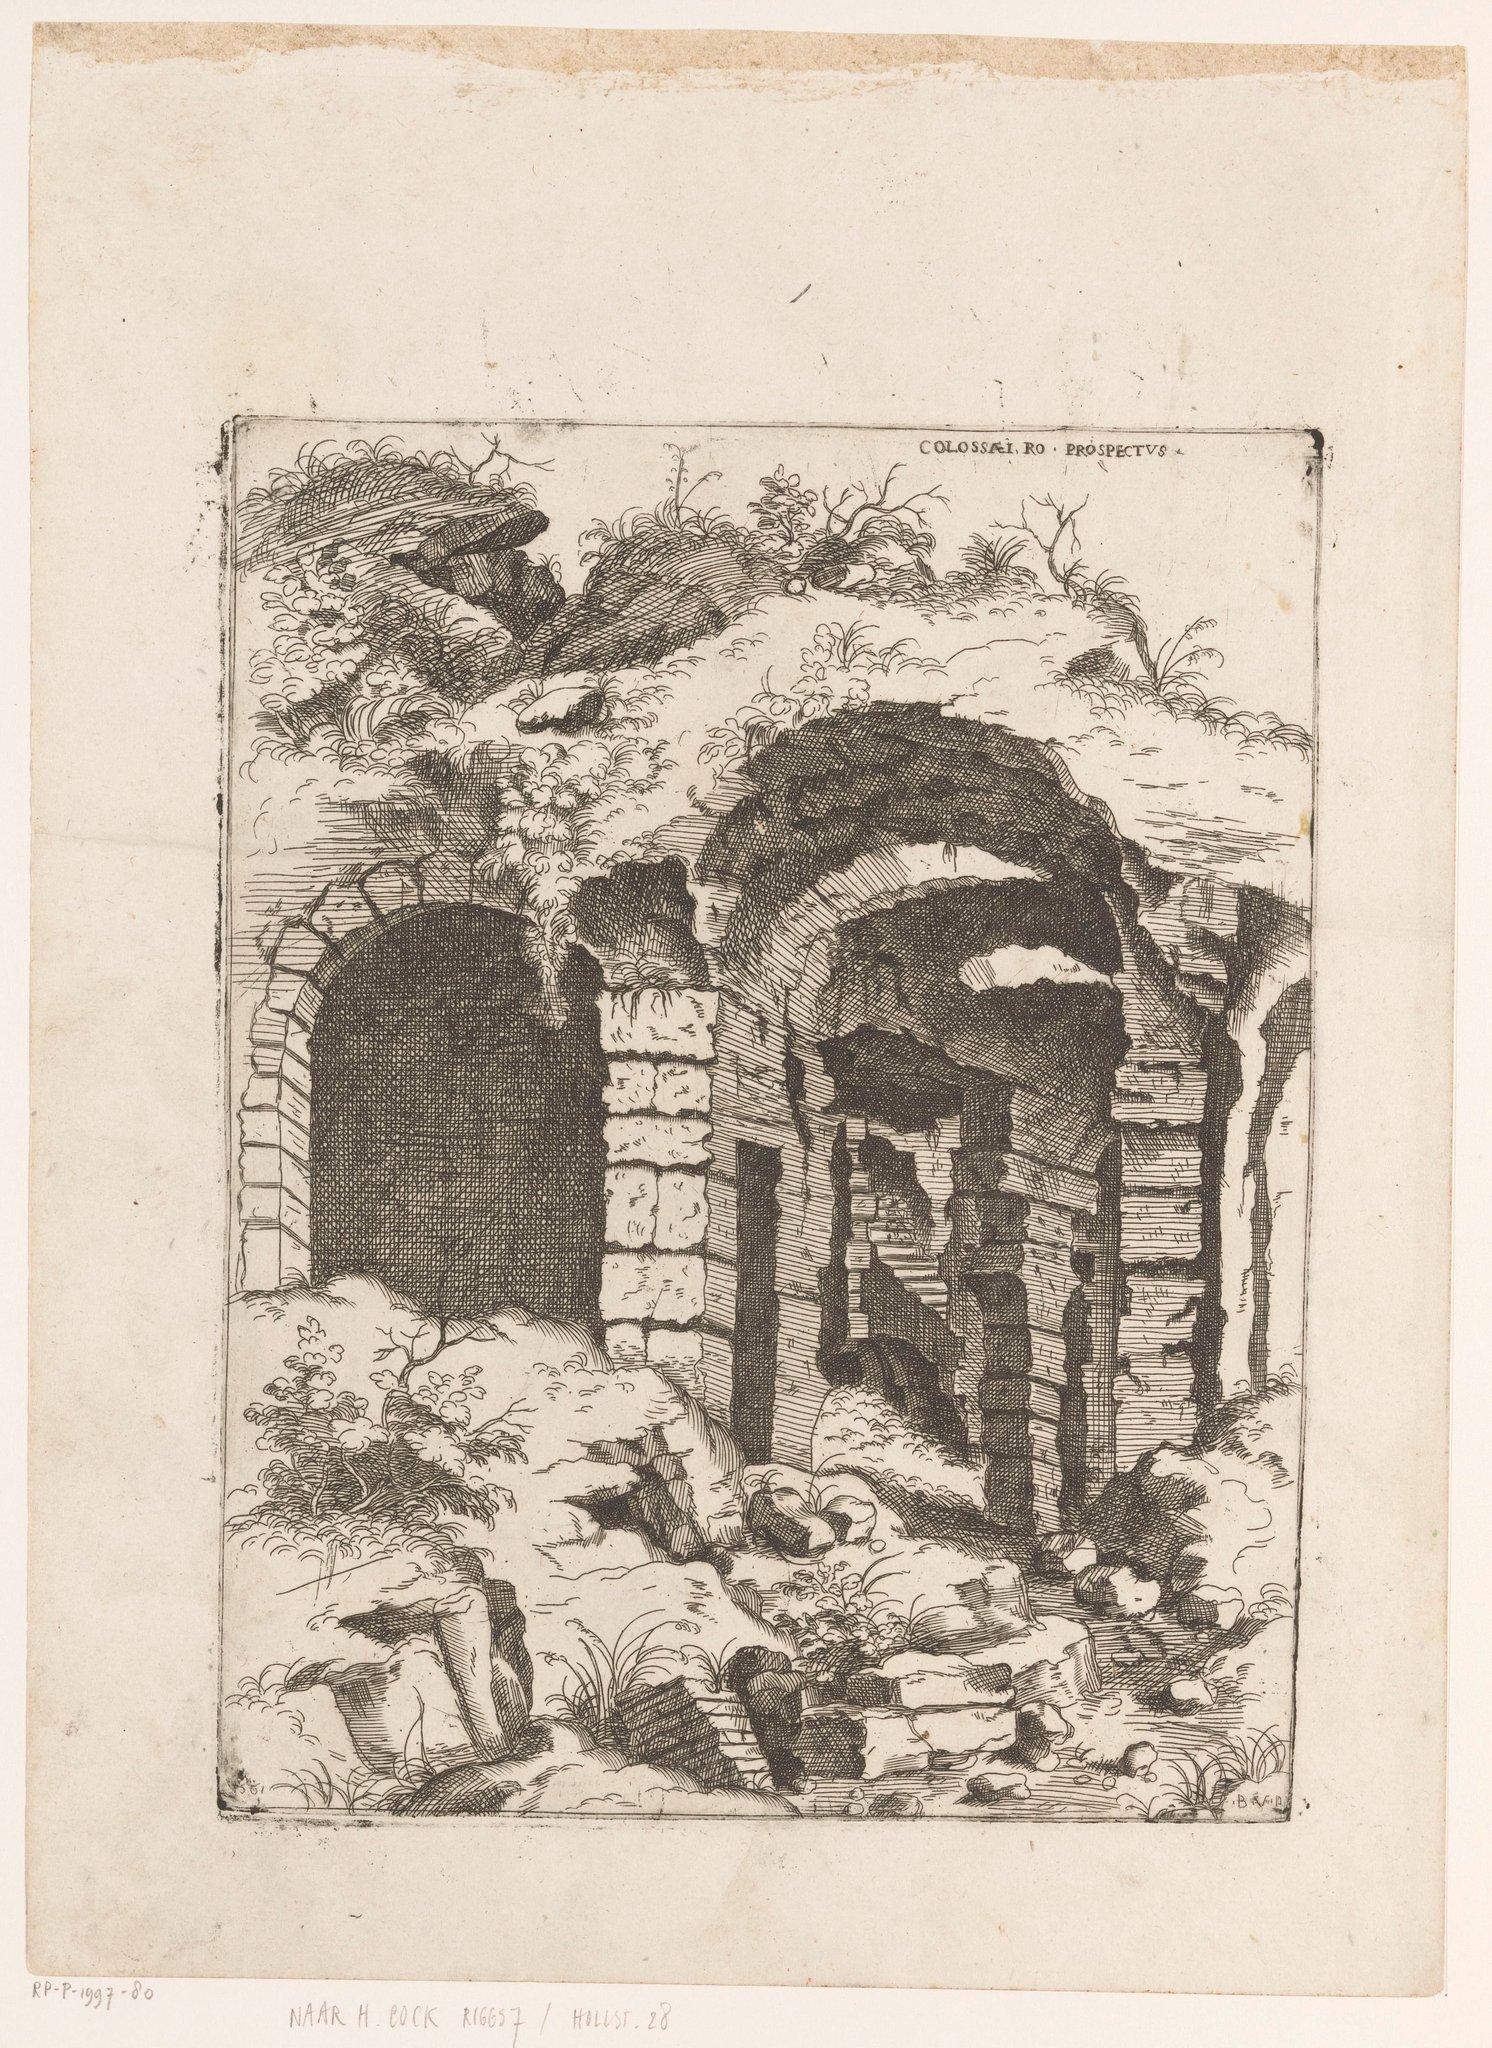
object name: book illustration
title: Colossaei ro prospectus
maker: giovanni battista pittoni (i)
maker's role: print maker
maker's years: 1520-1583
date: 1561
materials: paper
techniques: etching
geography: italy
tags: ruin of a building ~ architecture, landscape with ruins, theatre (building) - aa - open-air performances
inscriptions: collector's mark: Lugt 2228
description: Deze prent maakt deel uit van een reeks illustraties voor het traktaat van Vincenzo Scamozzi 'Discorsi sopra le antichità di Roma', Venetië 1582. De prenten zijn vrije kopieën naar een serie prenten van Hieronymus Cocks die voor het eerst werd uitgegeven in 1551 (Hollstein 22-47).